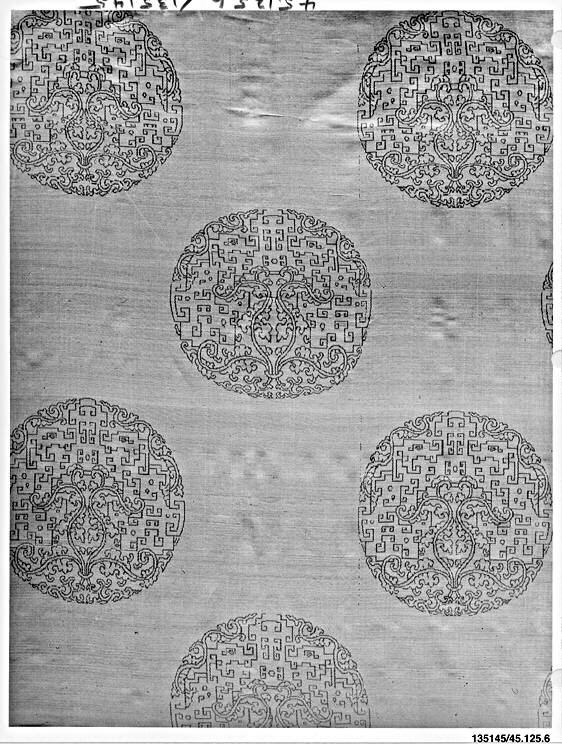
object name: piece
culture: chinese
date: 1801-1900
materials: silk